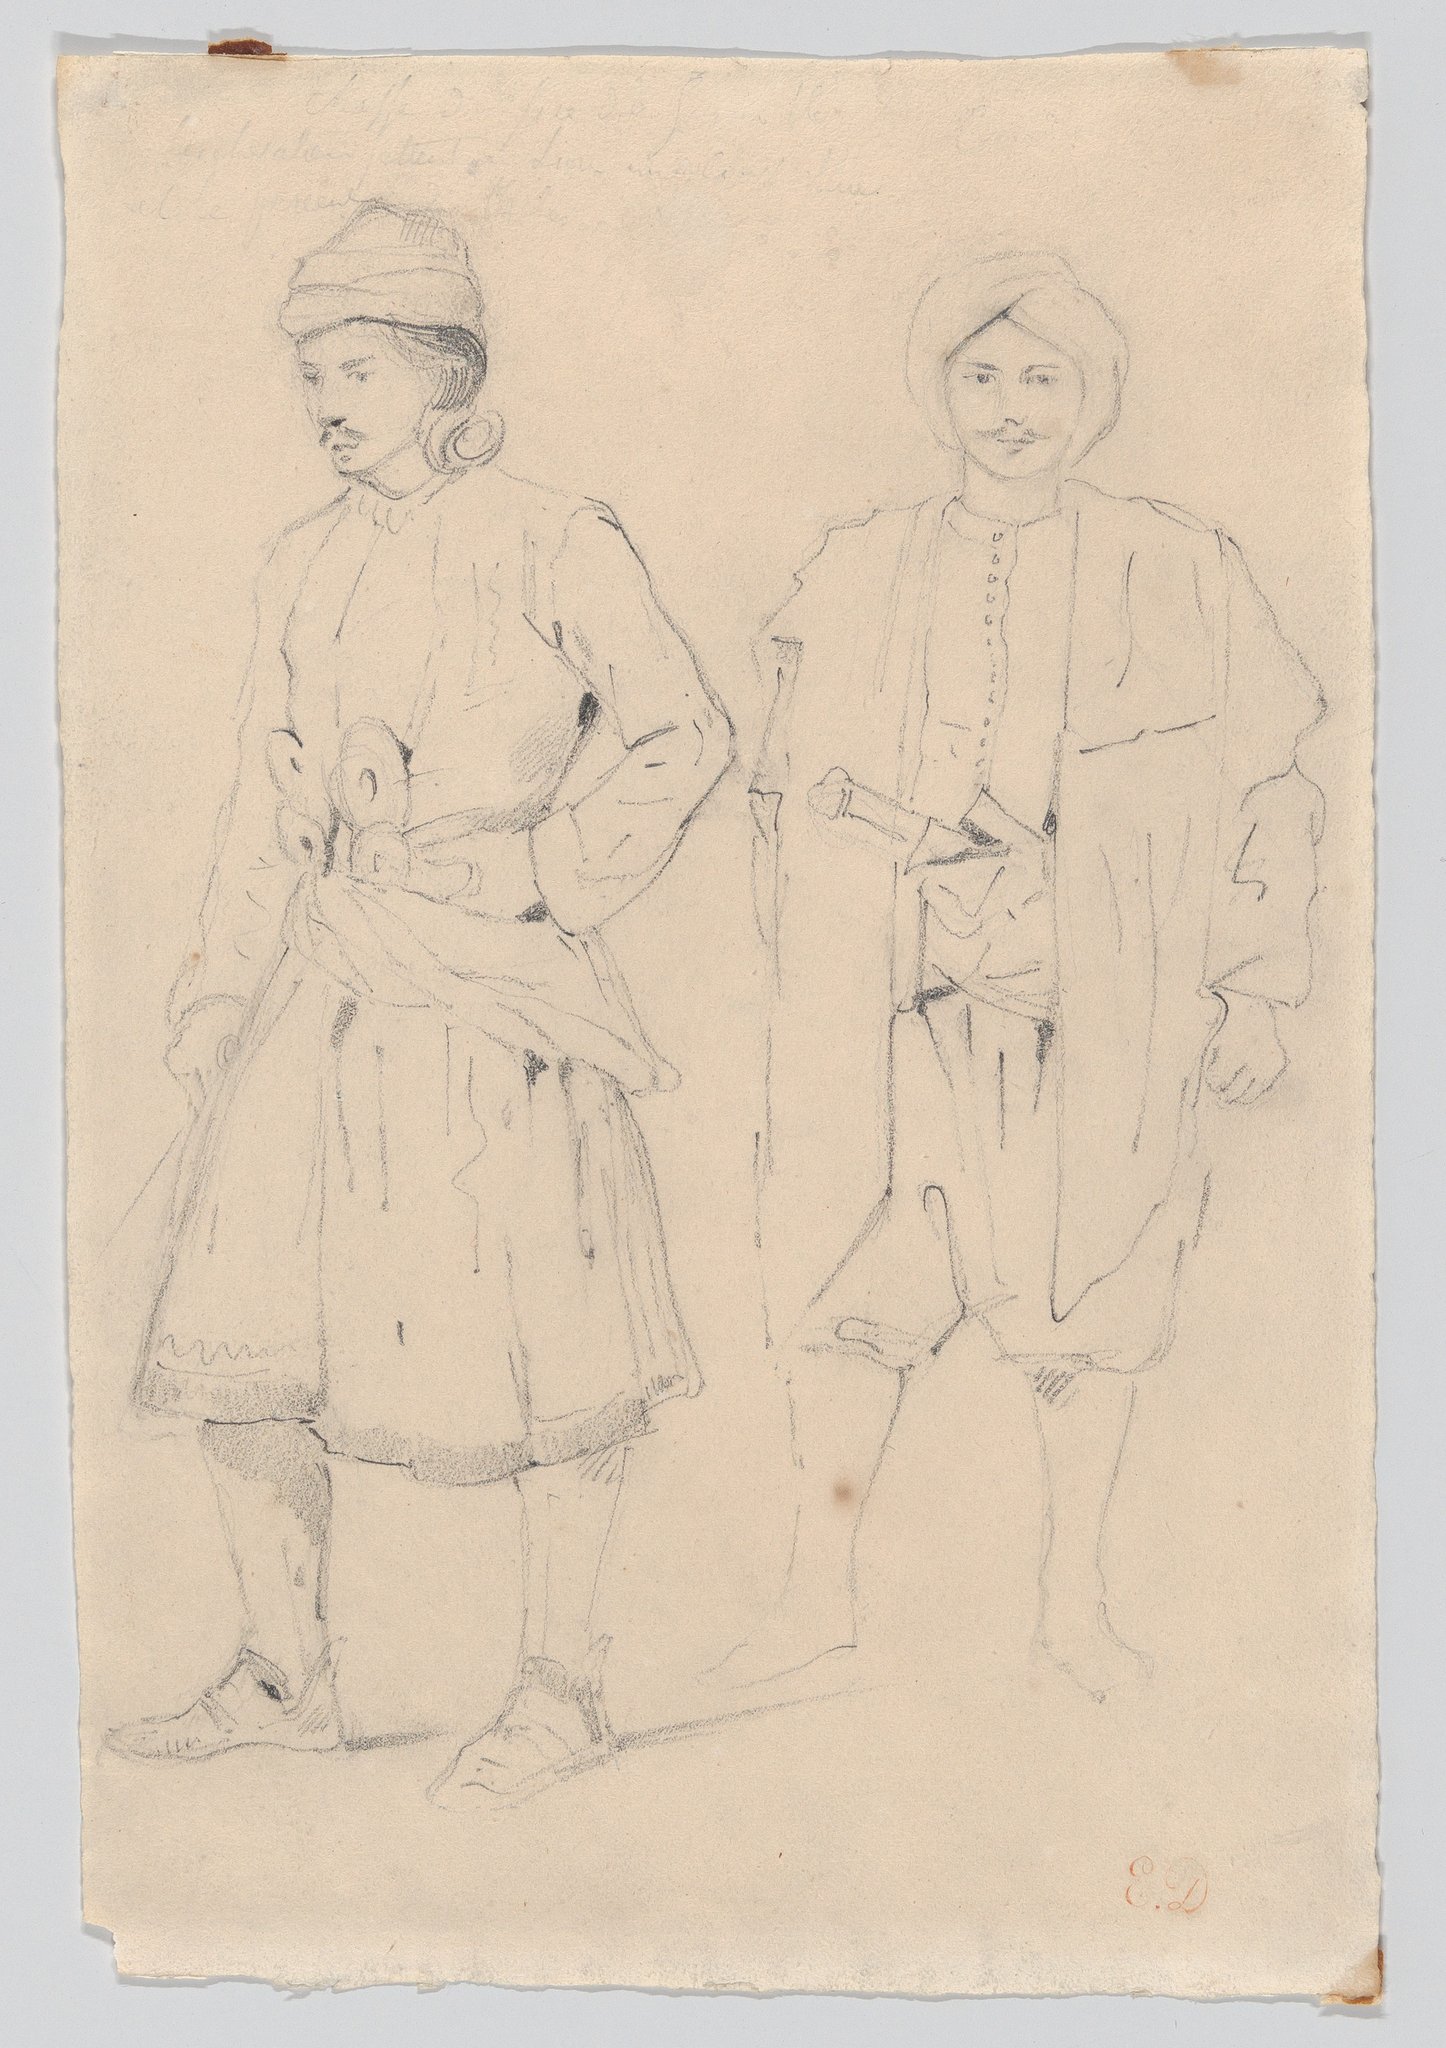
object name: drawing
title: Two Standing Turks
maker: eugène delacroix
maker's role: artist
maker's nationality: french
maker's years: 1798-1863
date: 1820-1863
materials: graphite